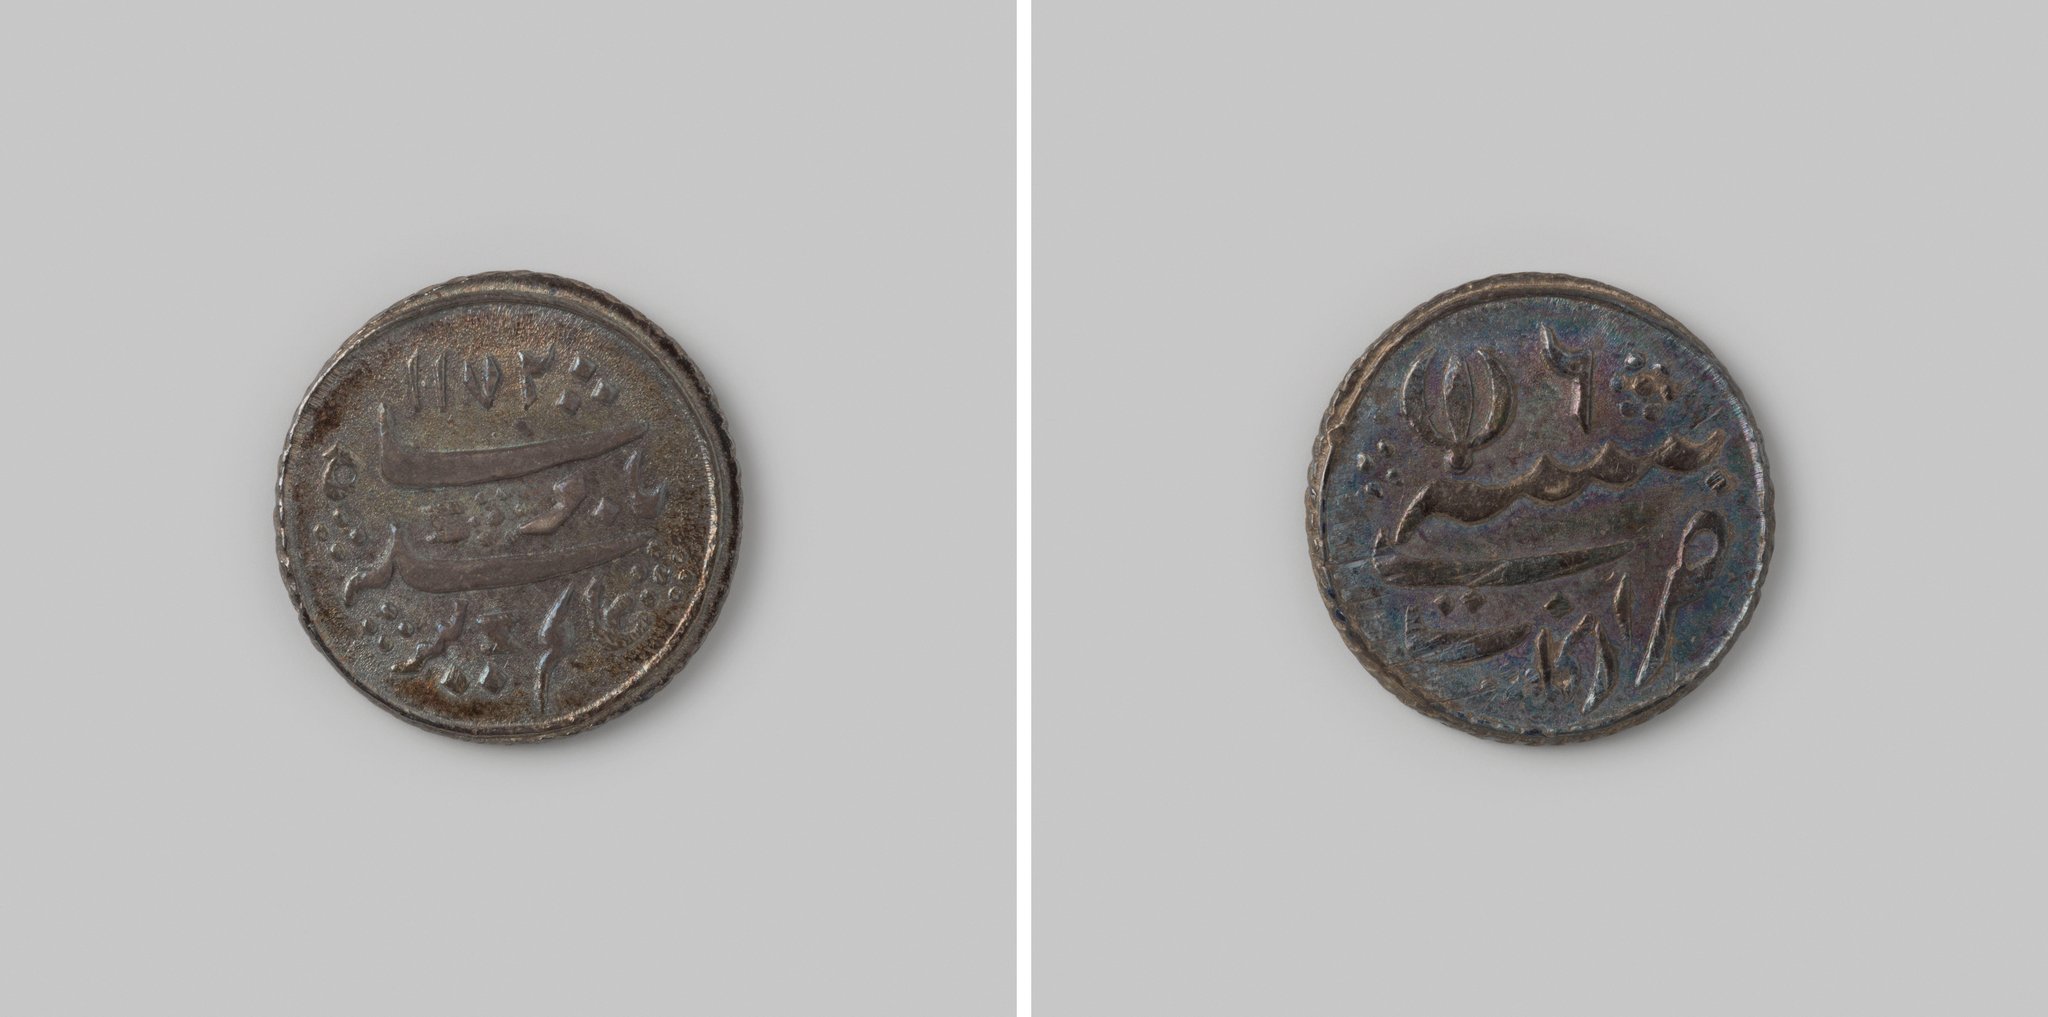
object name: coin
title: 1/8 arcot-roepie voor Madras in India van de Engelse Oostindische Compagnie (EIC), op naam van shah Alamgir II, (1807)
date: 1807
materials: silver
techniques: striking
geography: chennai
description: Zilveren munt. Voorzijde: opschrift in drie regels in Arabische lettertekens, waarin verwijzing naar shah Alamgir II. Bovenaan "bevroren" jaartal: 1172. Keerzijde: opschrift in drie regels in Arabische lettertekens. rechts aanduiding regeringsjaar: 6 en daarnaast lotusbloem. Kabelrand.